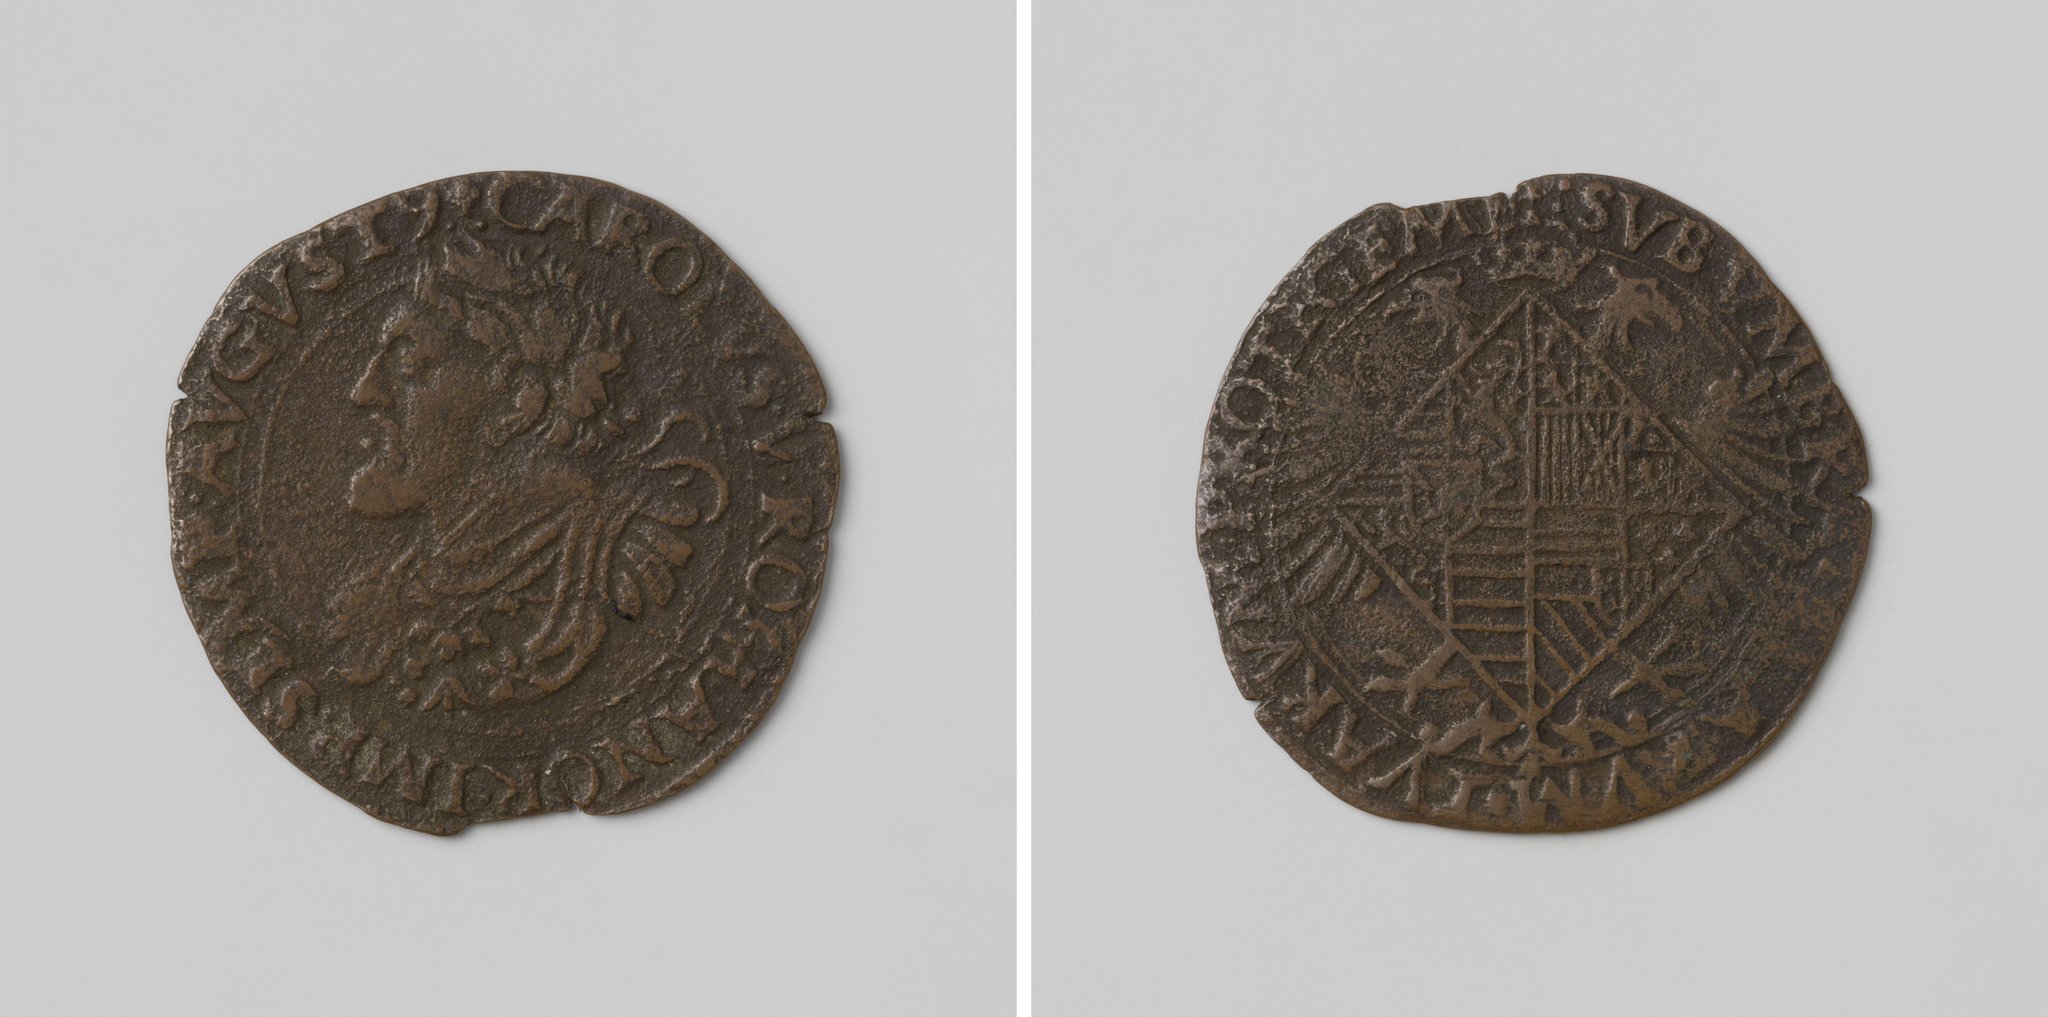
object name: jeton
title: Karel V, Duits keizer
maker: Anonymous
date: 1540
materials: copper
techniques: striking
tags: ghent, charles v (holy roman emperor and king of spain)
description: Koperen penning. Voorzijde: borststuk man met lauwerkrans binnen omschrift. Keerzijde: tweekoppige adelaar onder kroon met ruitvormig wapenschild binnen omschrift